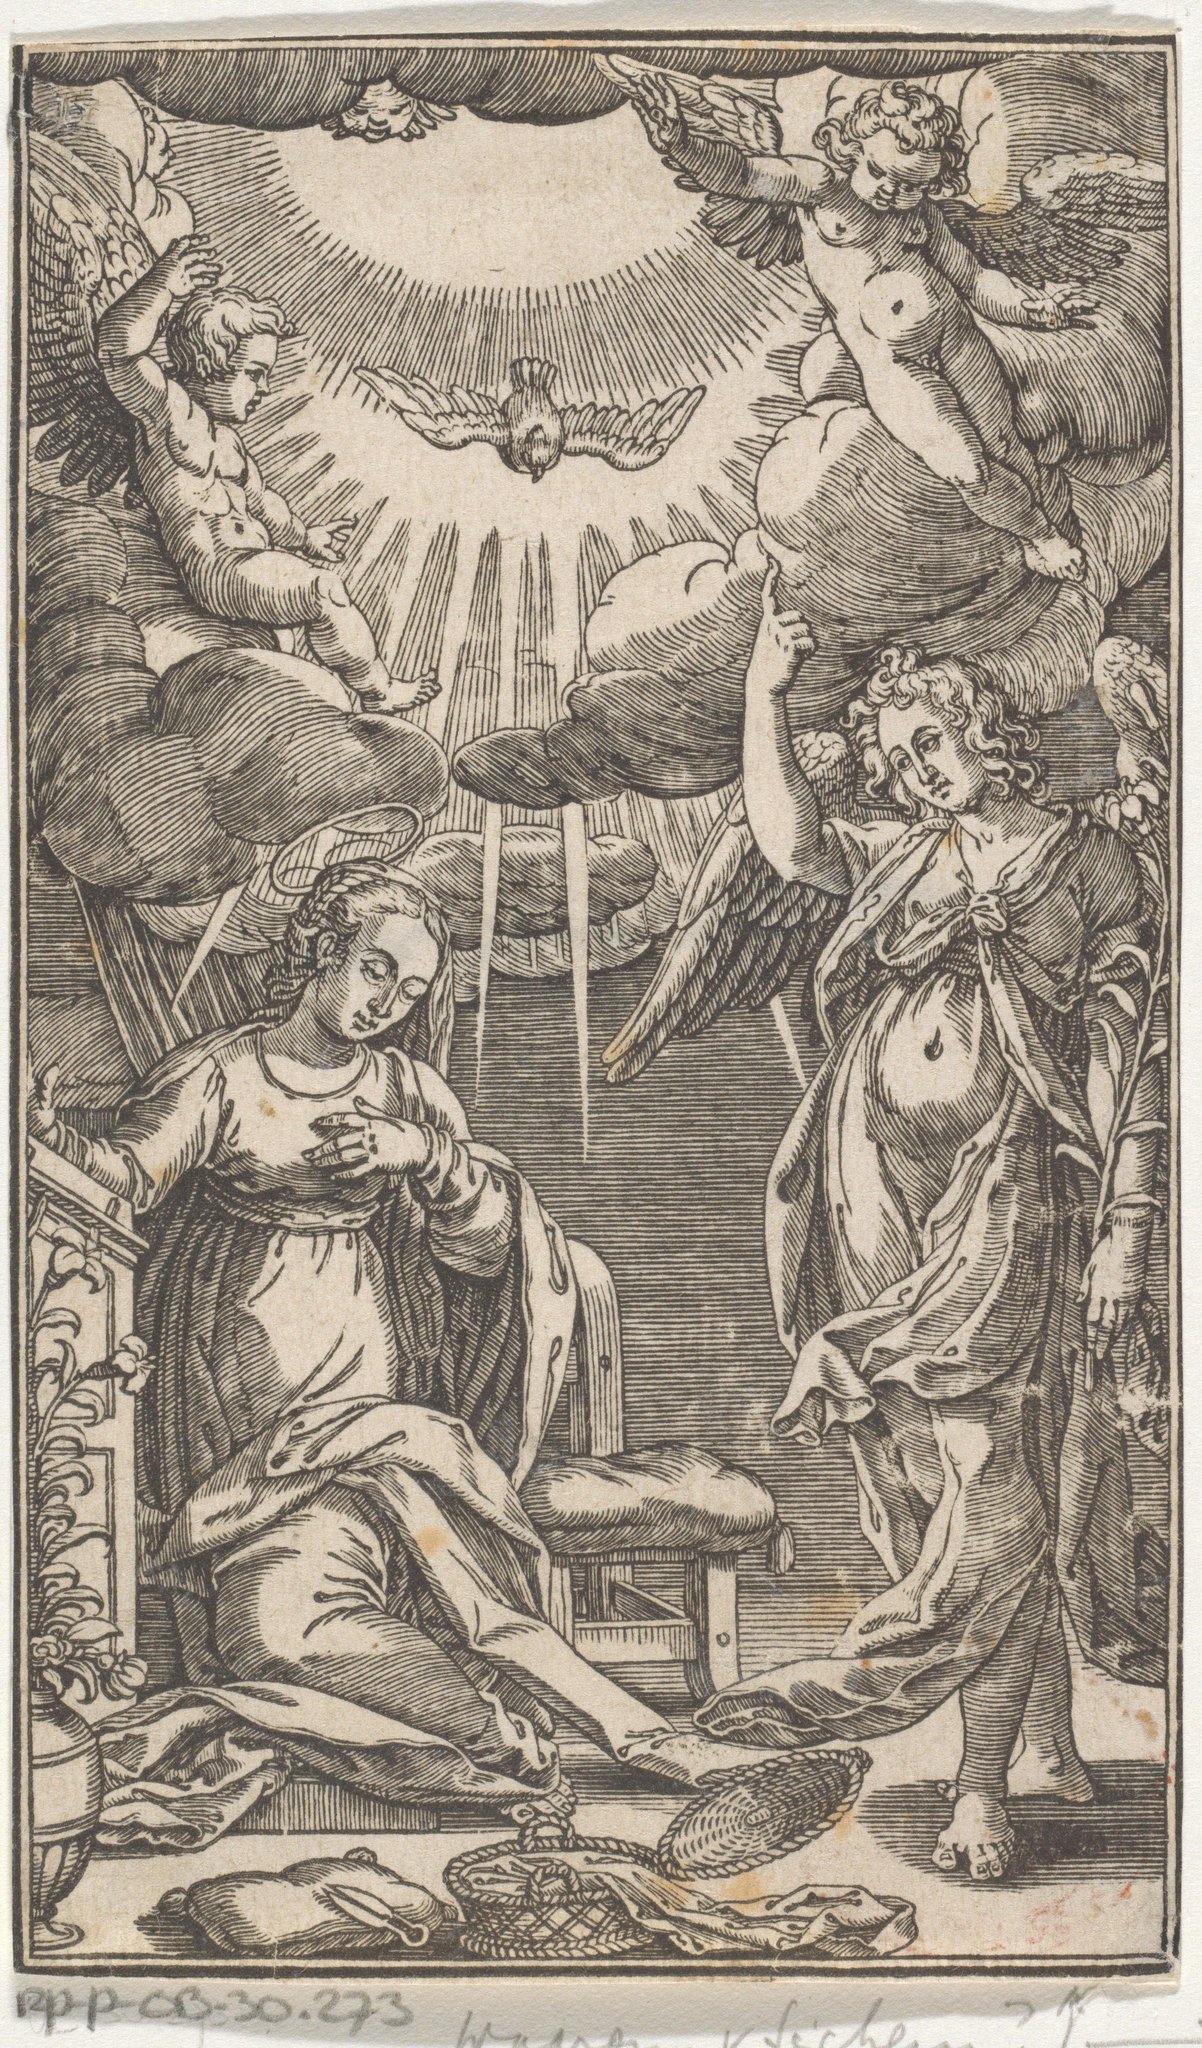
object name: print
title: Annunciatie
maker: christoffel van sichem (ii)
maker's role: print maker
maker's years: 1581-1658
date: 1581-1658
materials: paper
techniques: woodcut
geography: amsterdam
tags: the annunciation: mary, usually reading, is visited by the angel (sometimes a woman overhears the conversation)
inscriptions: collector's mark: Lugt 240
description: Een engel kondigt aan Maria aan dat ze zwanger zal worden. Midden boven daalt de Heilige Geest als een duif neer. Op de voorgrond staat een vaas met lelies en ligt haar naaiwerk.